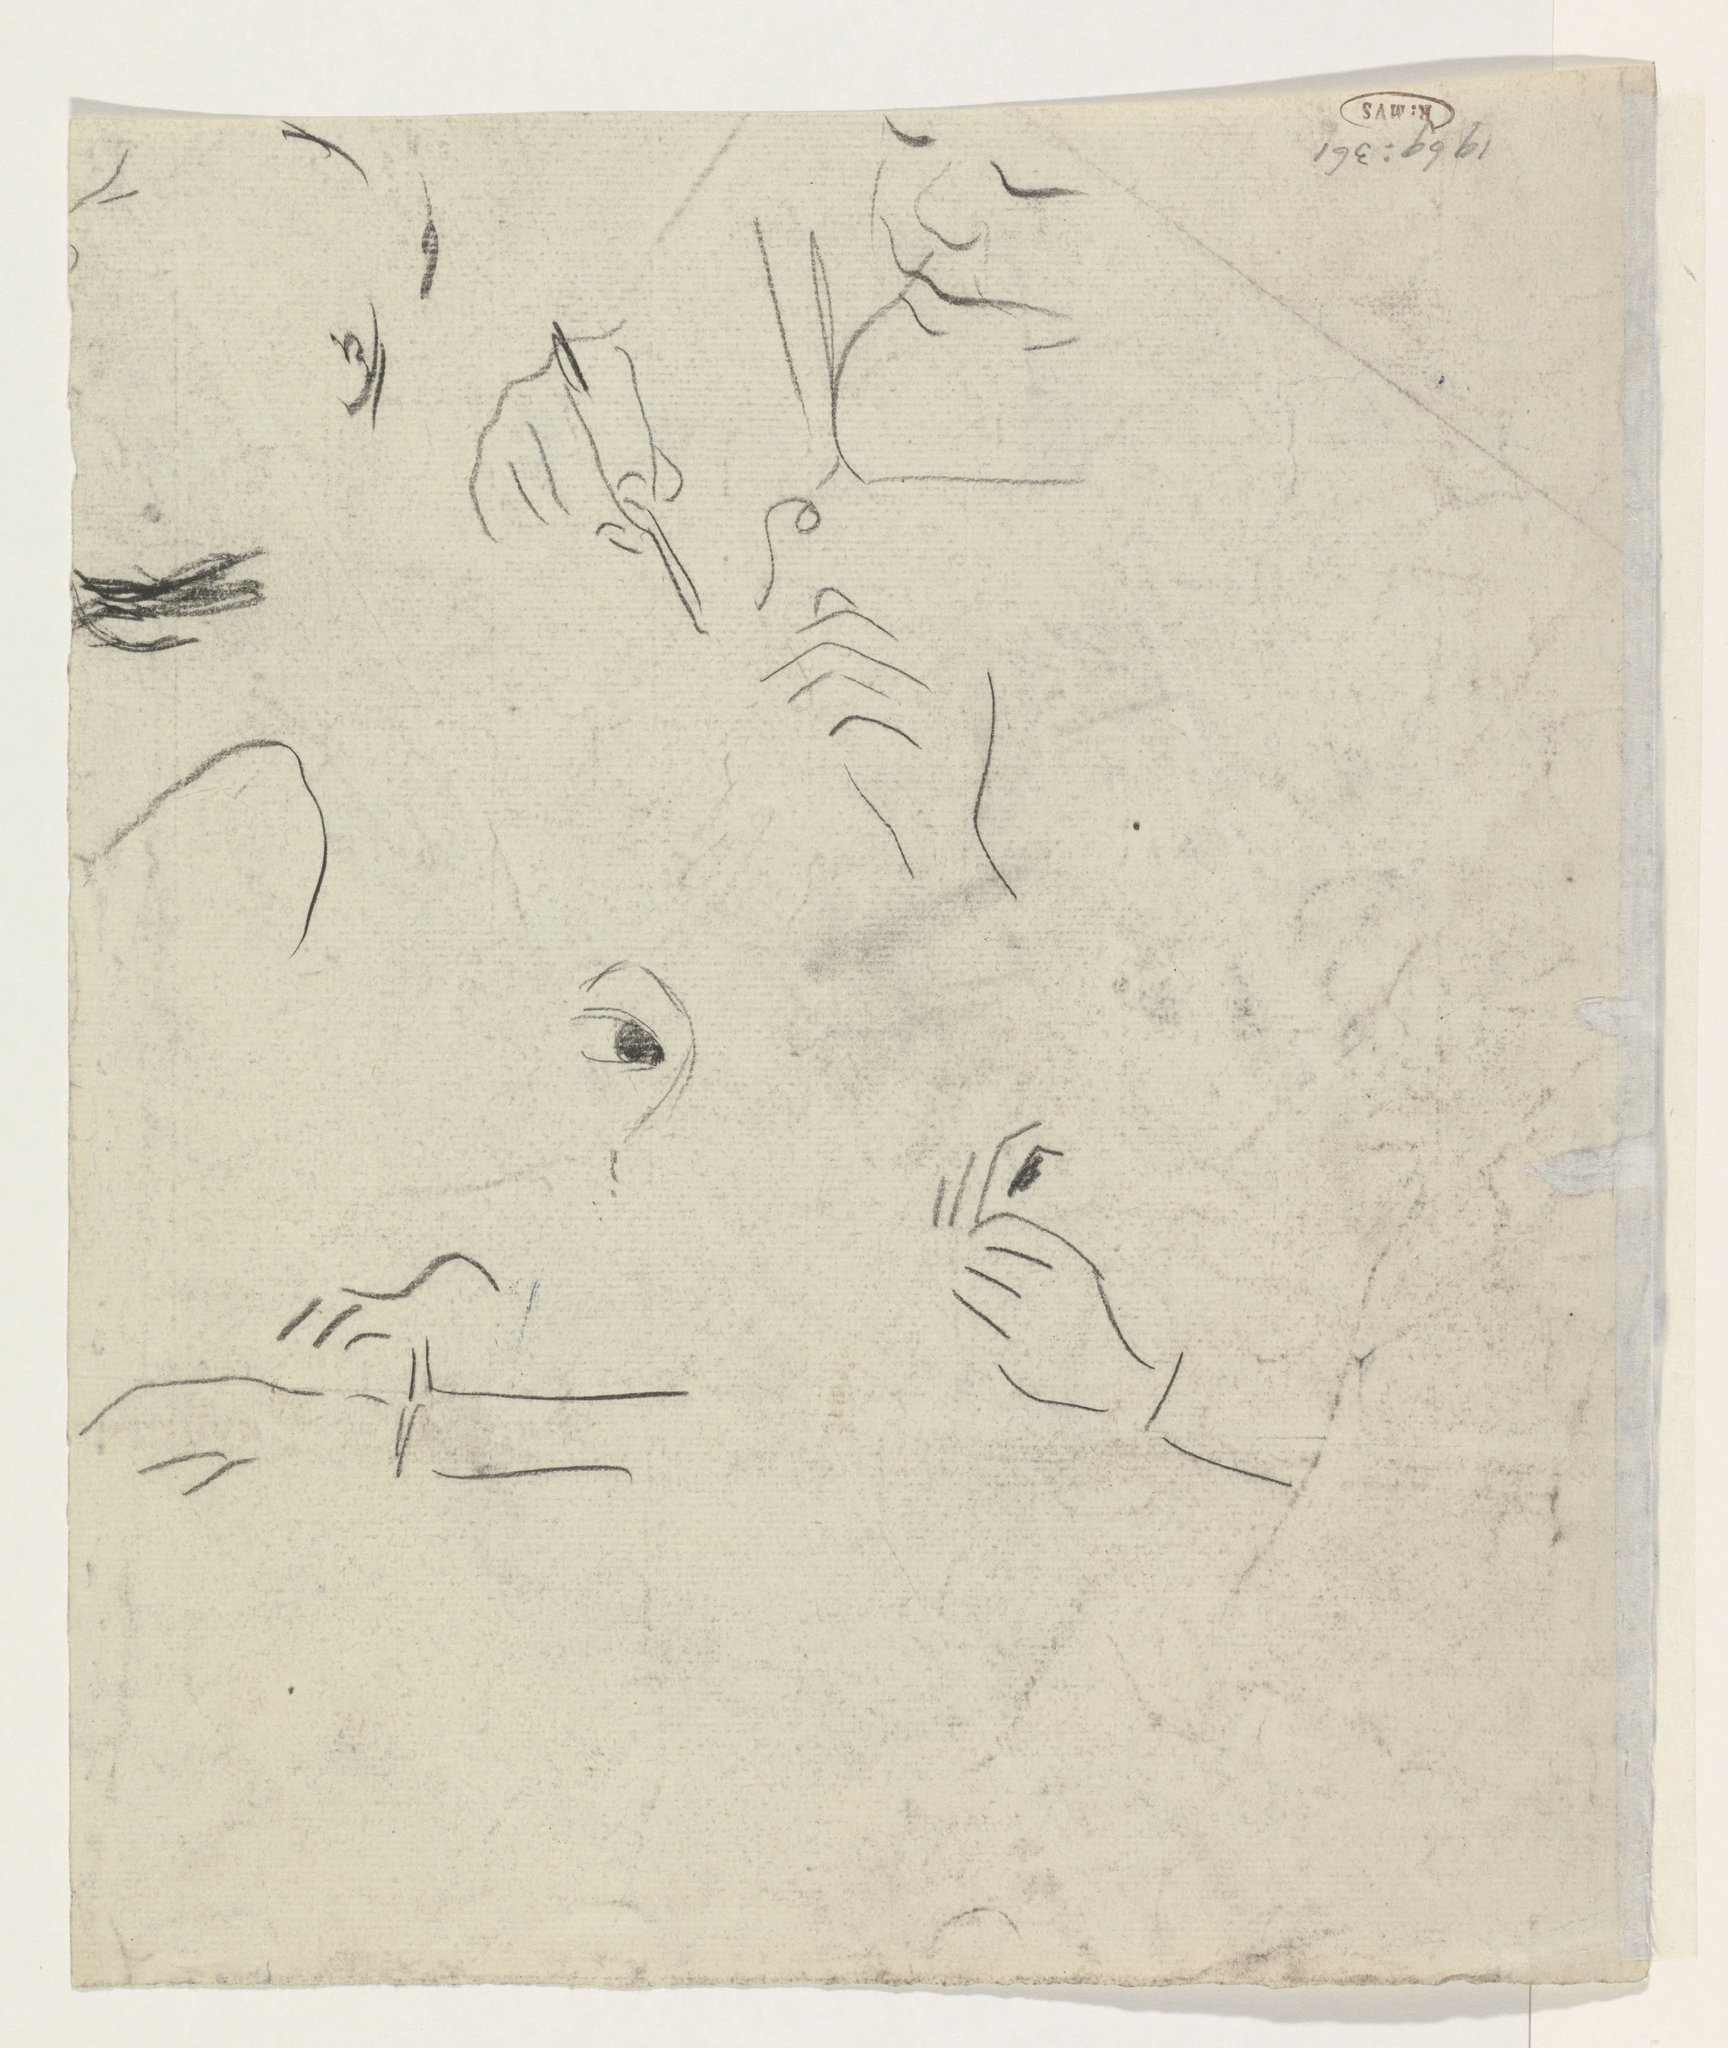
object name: drawing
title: Studies van handen en ogen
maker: carel adolph lion cachet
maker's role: draughtsman, print maker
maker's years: 1864-1945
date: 1874-1945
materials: chalk, paper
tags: hand, eyes